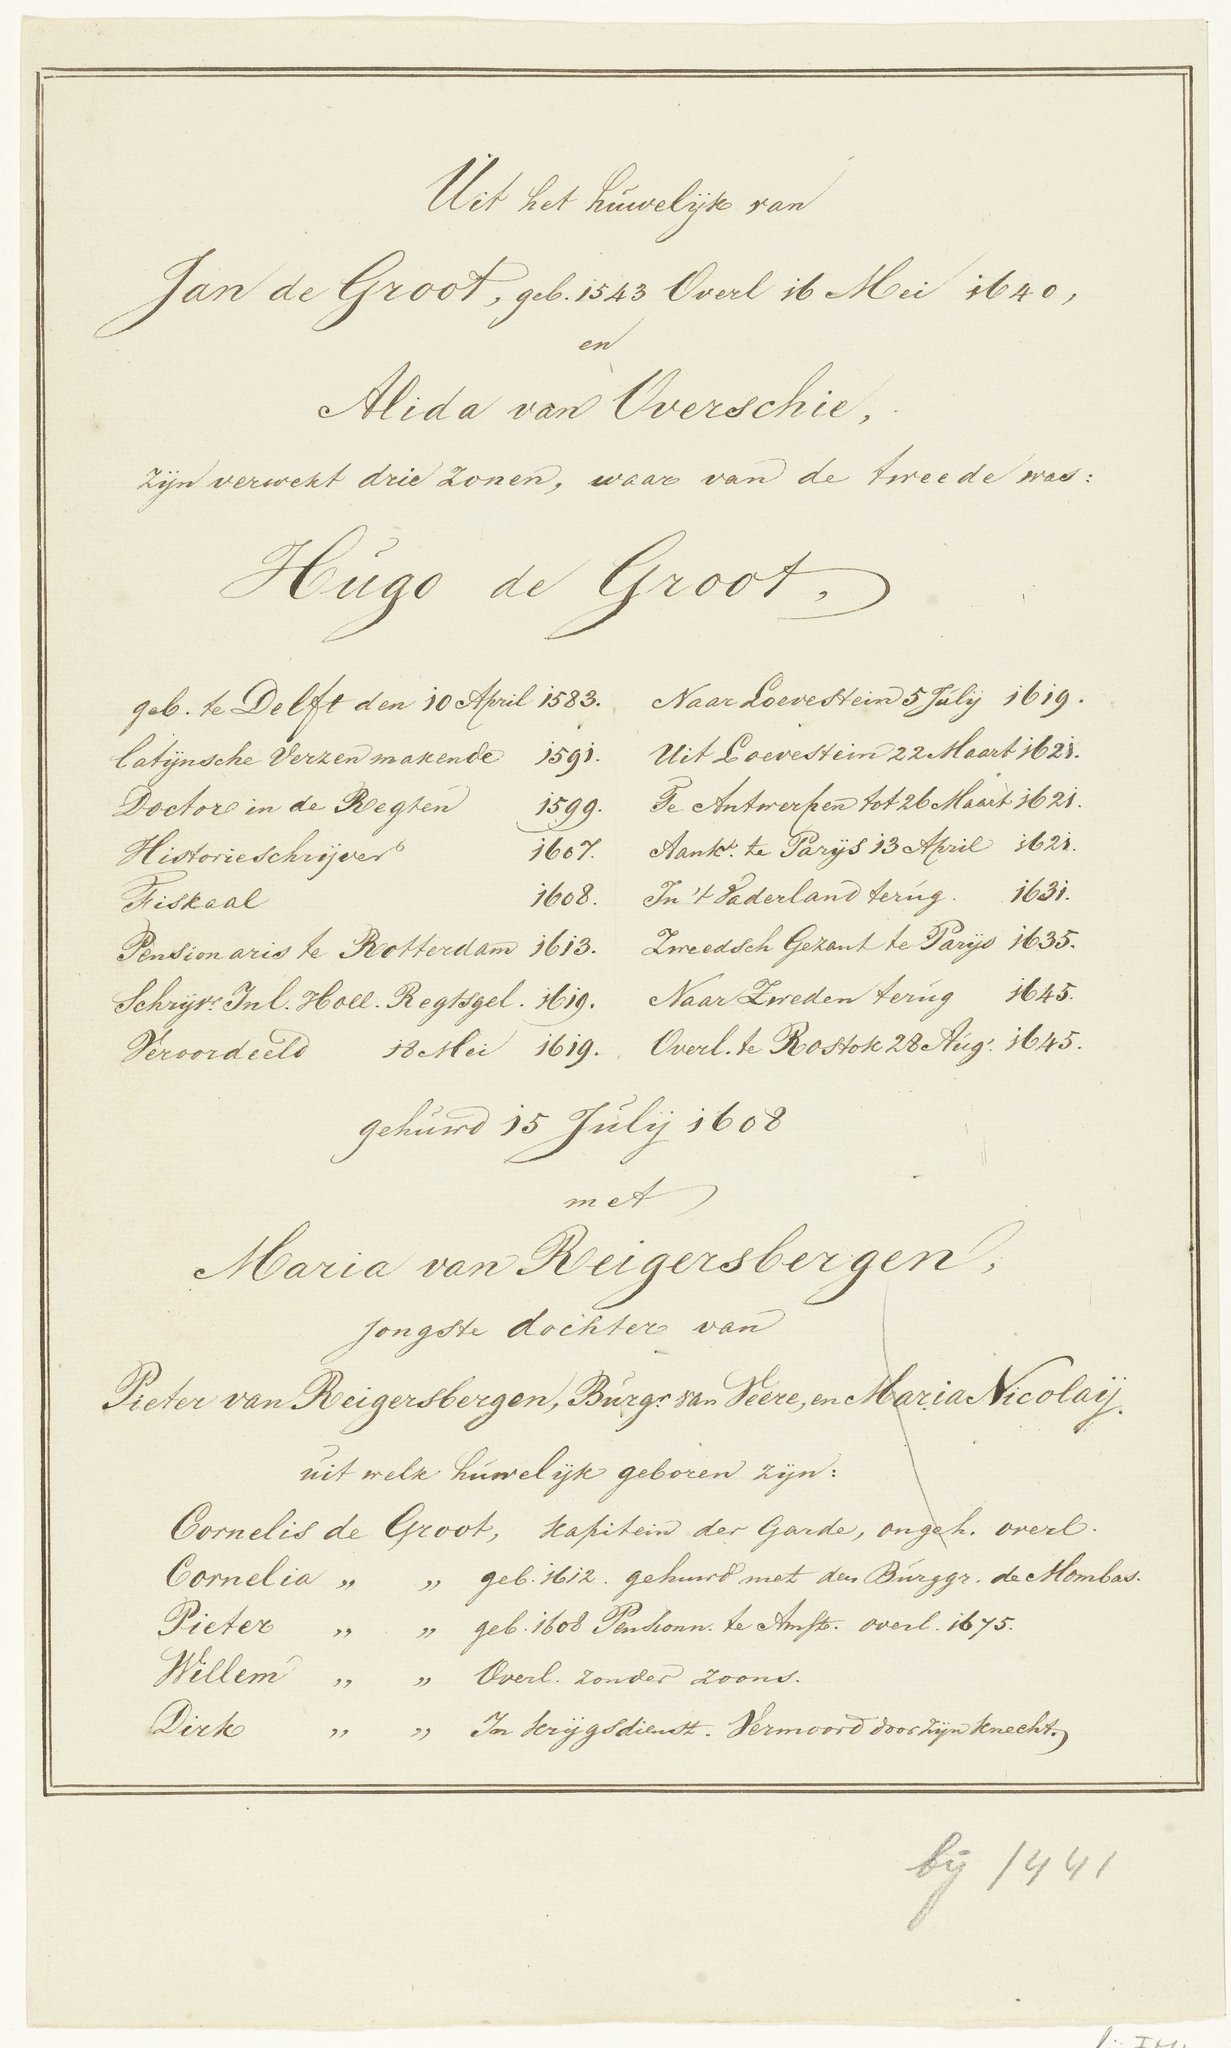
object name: text sheet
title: Blad met biografische gegevens over Hugo de Groot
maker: Anonymous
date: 1800-1899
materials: paper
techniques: pen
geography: netherlands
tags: delft, hugo de groot, the hague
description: Blad met biografische gegevens over Hugo de Groot, zijn ouders, zijn huwelijk met Maria van Reigersberch en hun kinderen.